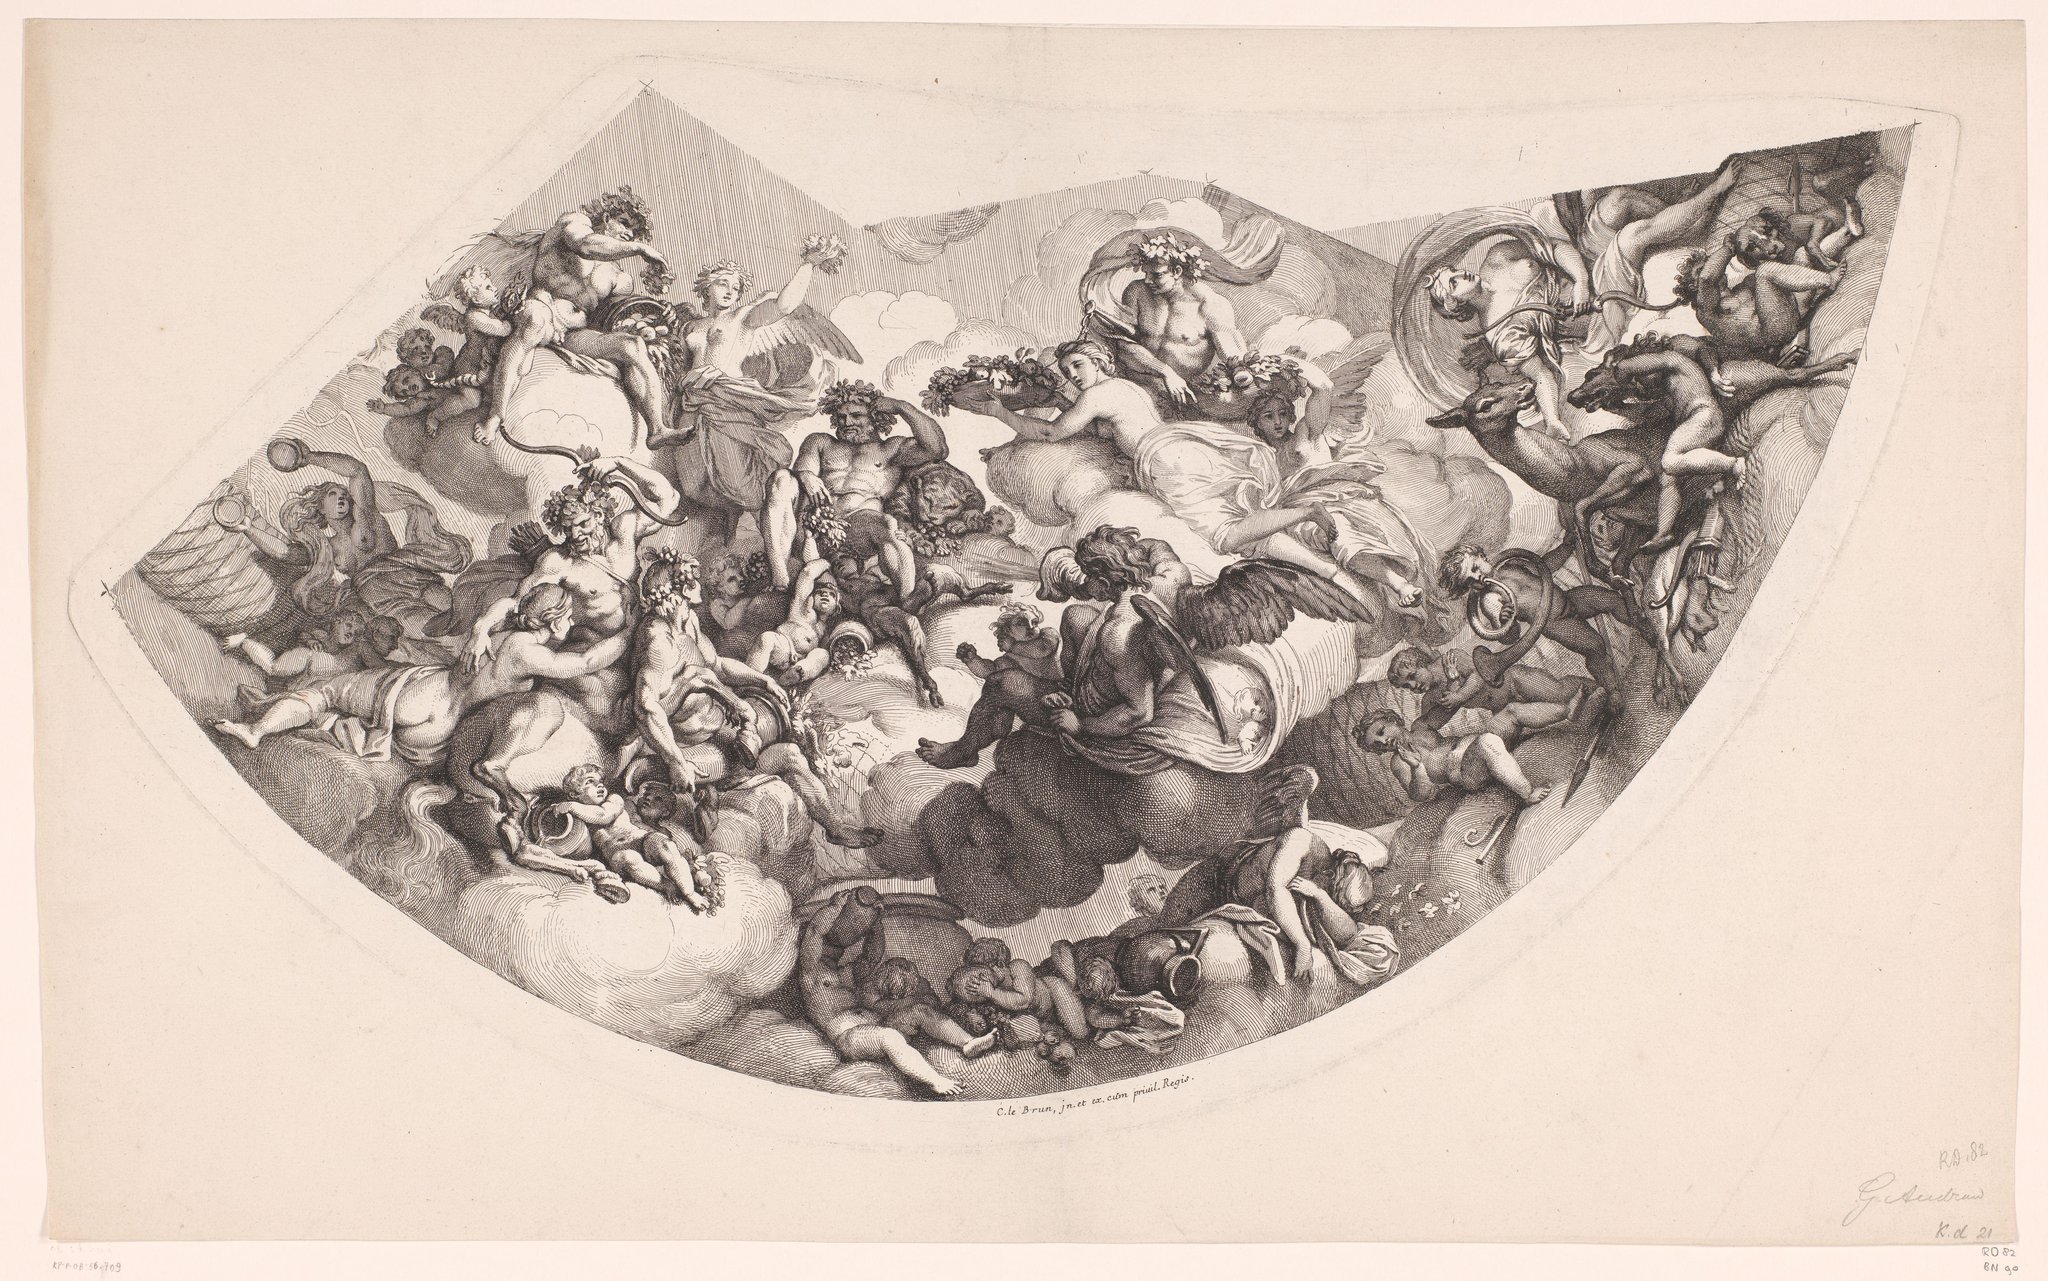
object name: print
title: Bijeenkomst van de goden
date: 1650-1690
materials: paper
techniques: engraving, etching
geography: france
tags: the olympian gods together: jupiter, juno, neptune, ceres, apollo, diana, mars, venus, mercury, minerva, vulcan, vesta (or bacchus), (decorated) ceiling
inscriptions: collector's mark: Lugt 240